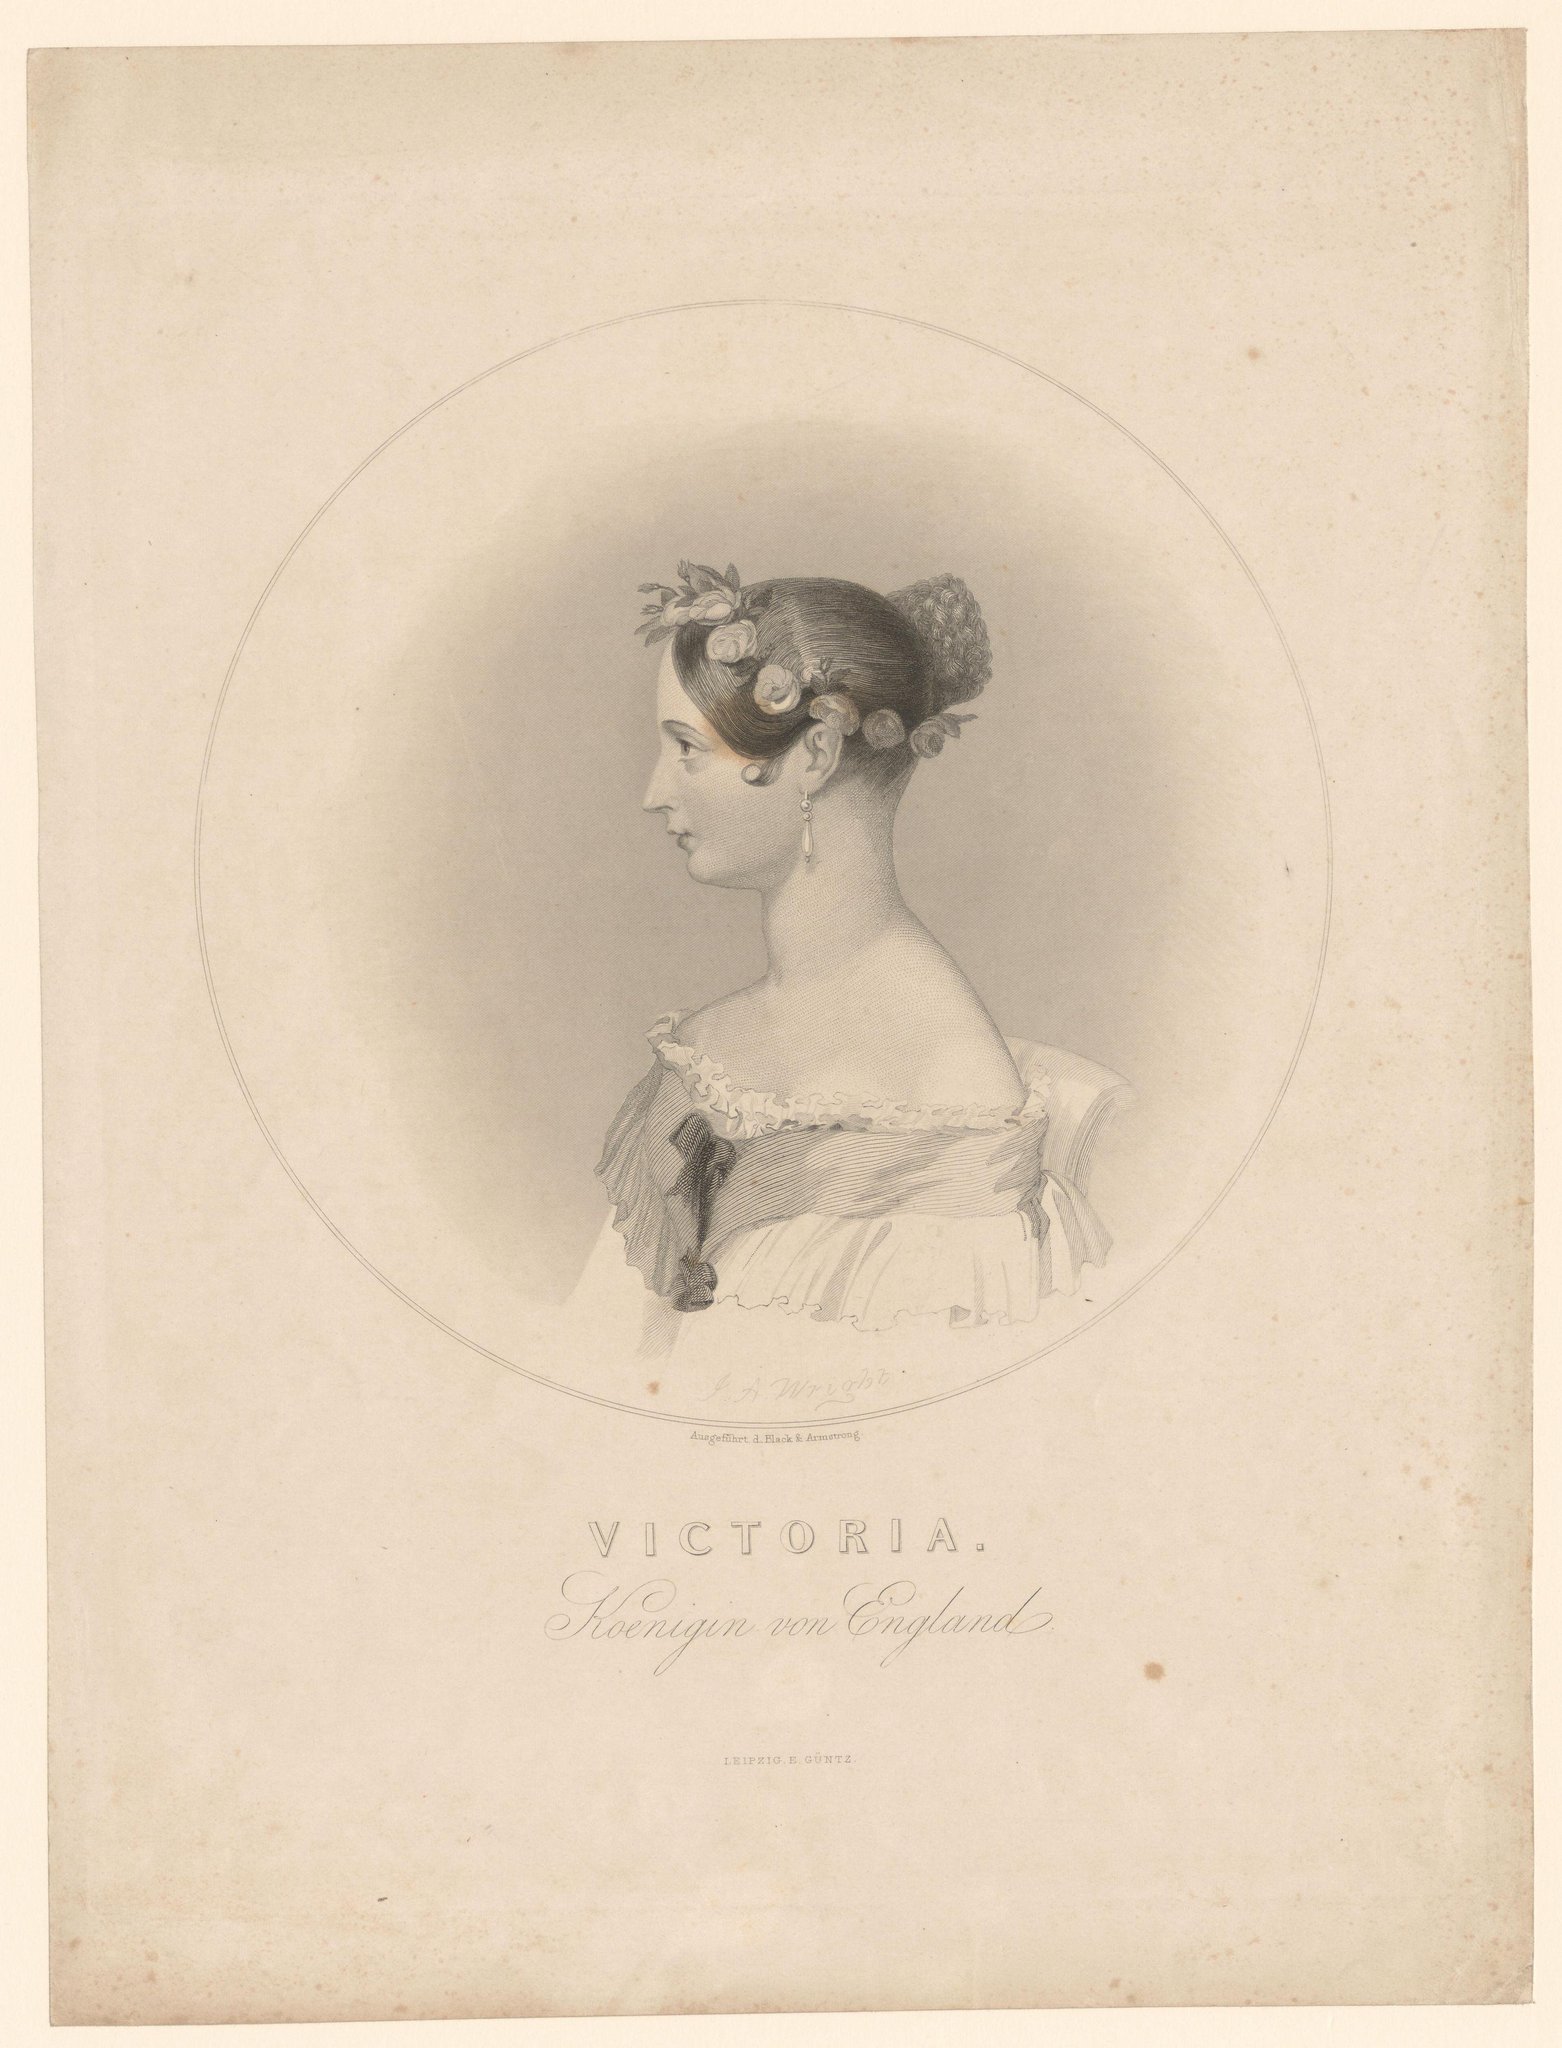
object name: print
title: Victoria / Koenigin von England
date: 1837-1838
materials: paper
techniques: engraving, etching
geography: leipzig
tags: victoria (koningin van het verenigd koninkrijk en keizerin van india), historical persons, queen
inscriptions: collector's mark: Lugt 2228